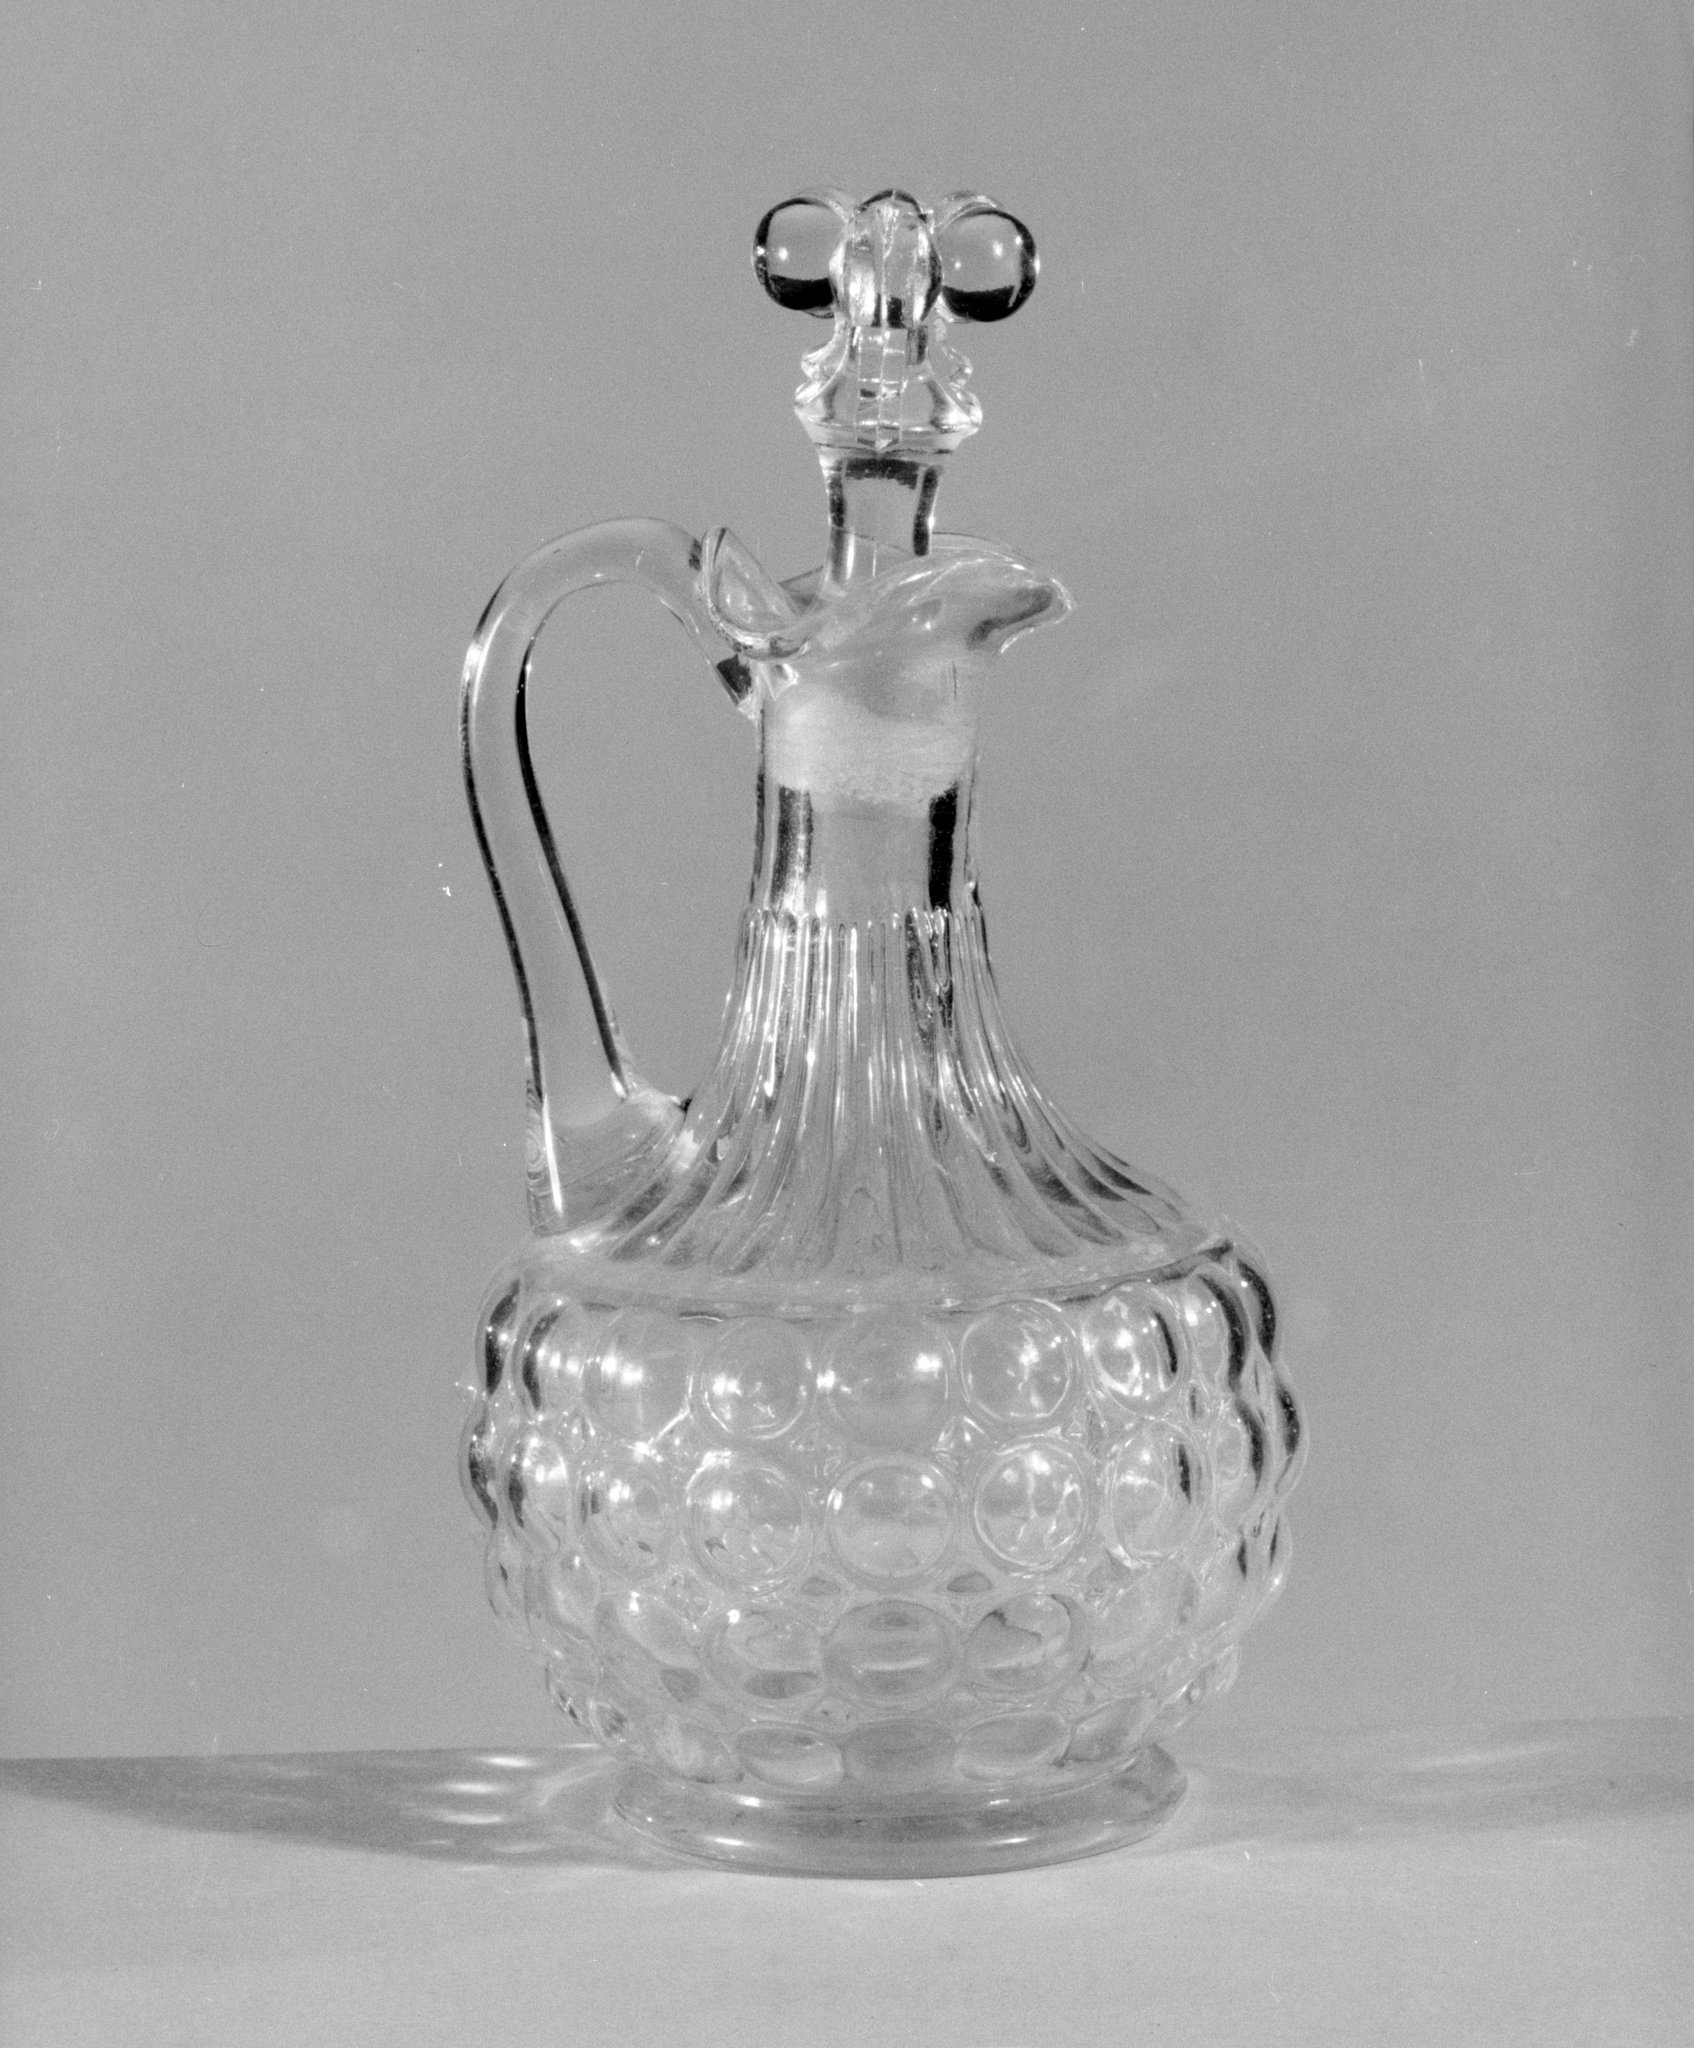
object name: cruet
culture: american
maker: adams and company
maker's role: maker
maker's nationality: american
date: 1870-1890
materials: glass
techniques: pressed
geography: united states